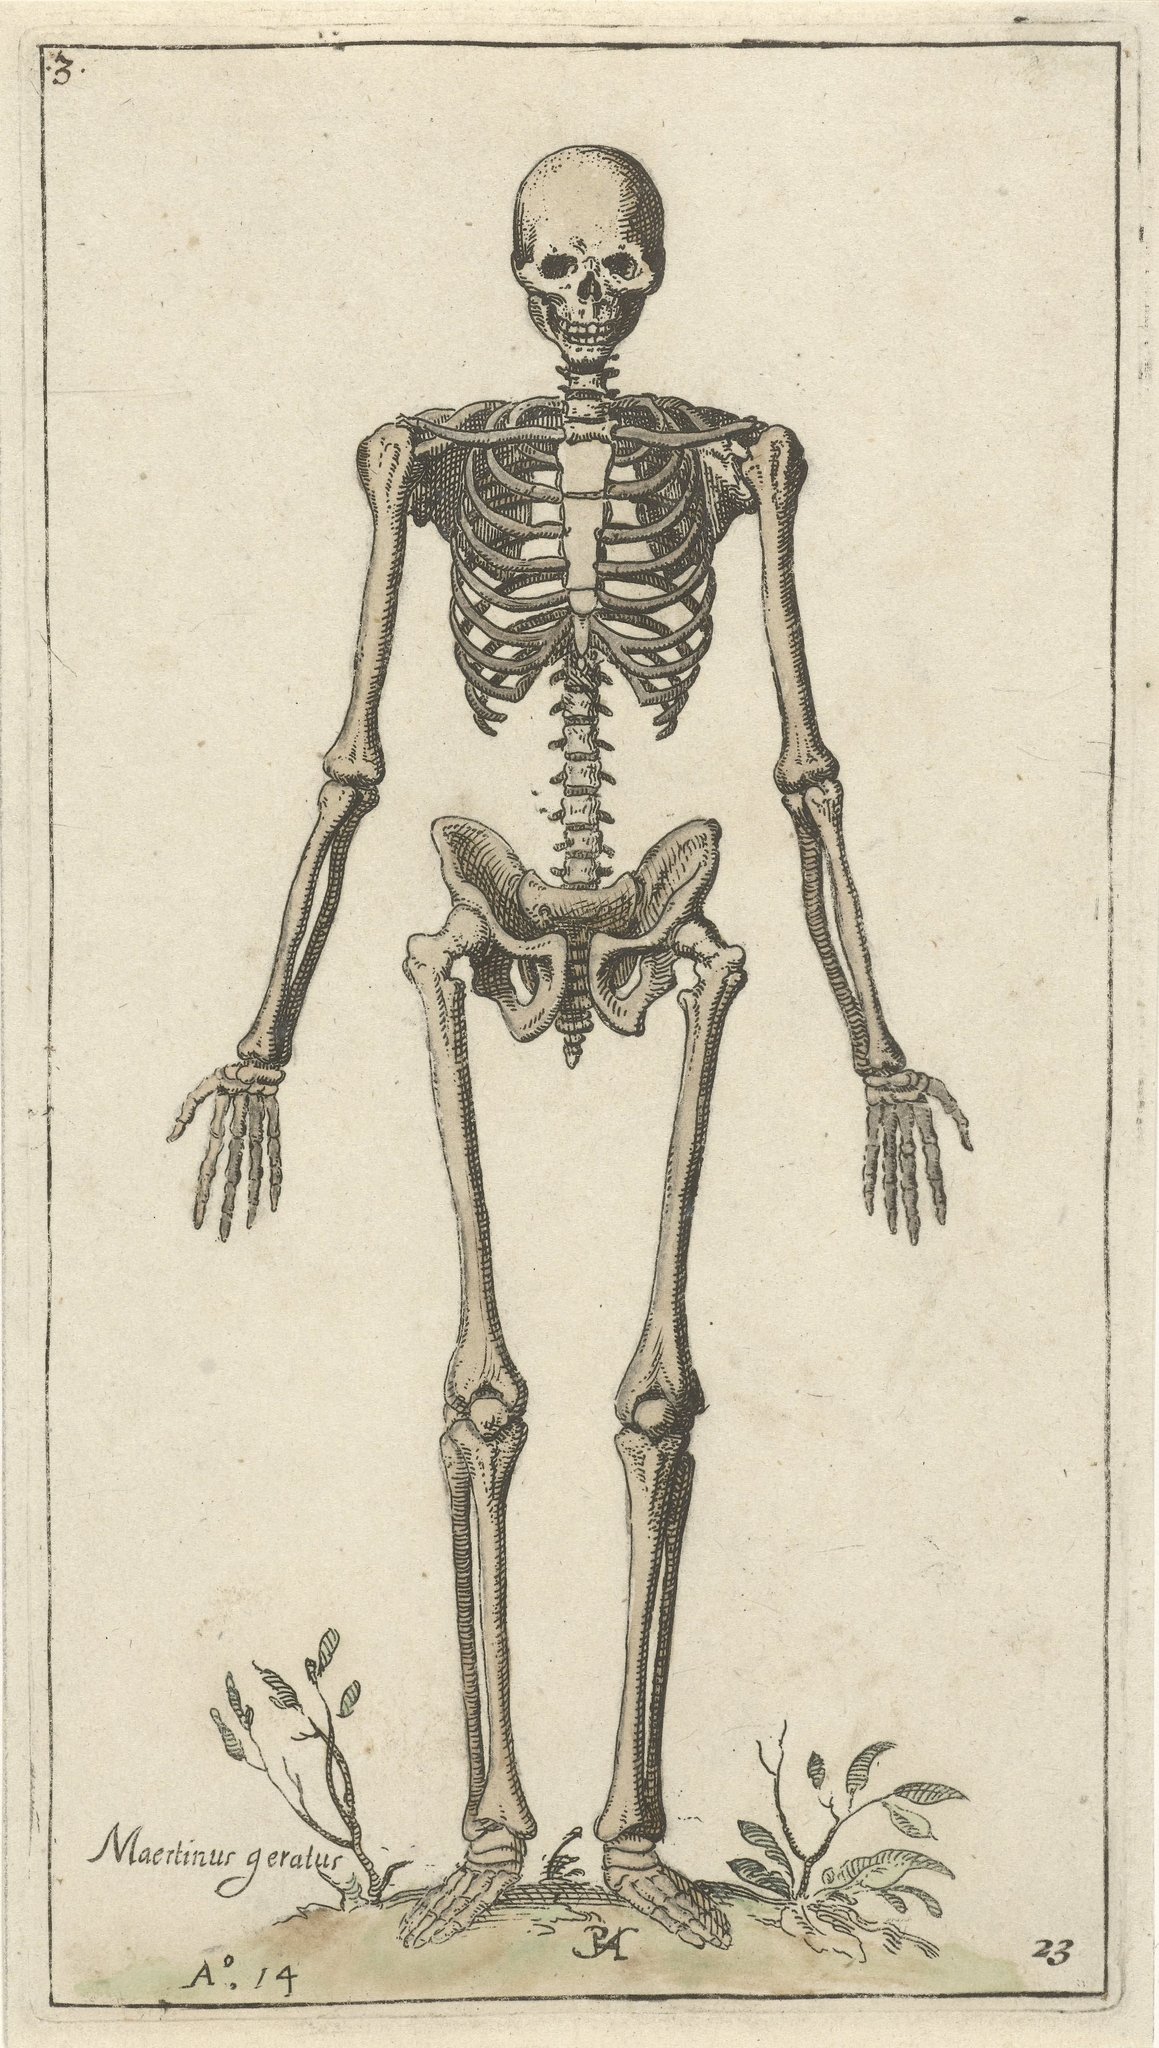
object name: print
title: Mannelijk skelet, van voren gezien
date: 1614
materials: paper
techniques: etching, hand coloring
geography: bruges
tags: anatomical model of the skeletal system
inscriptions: collector's mark: Lugt 2228